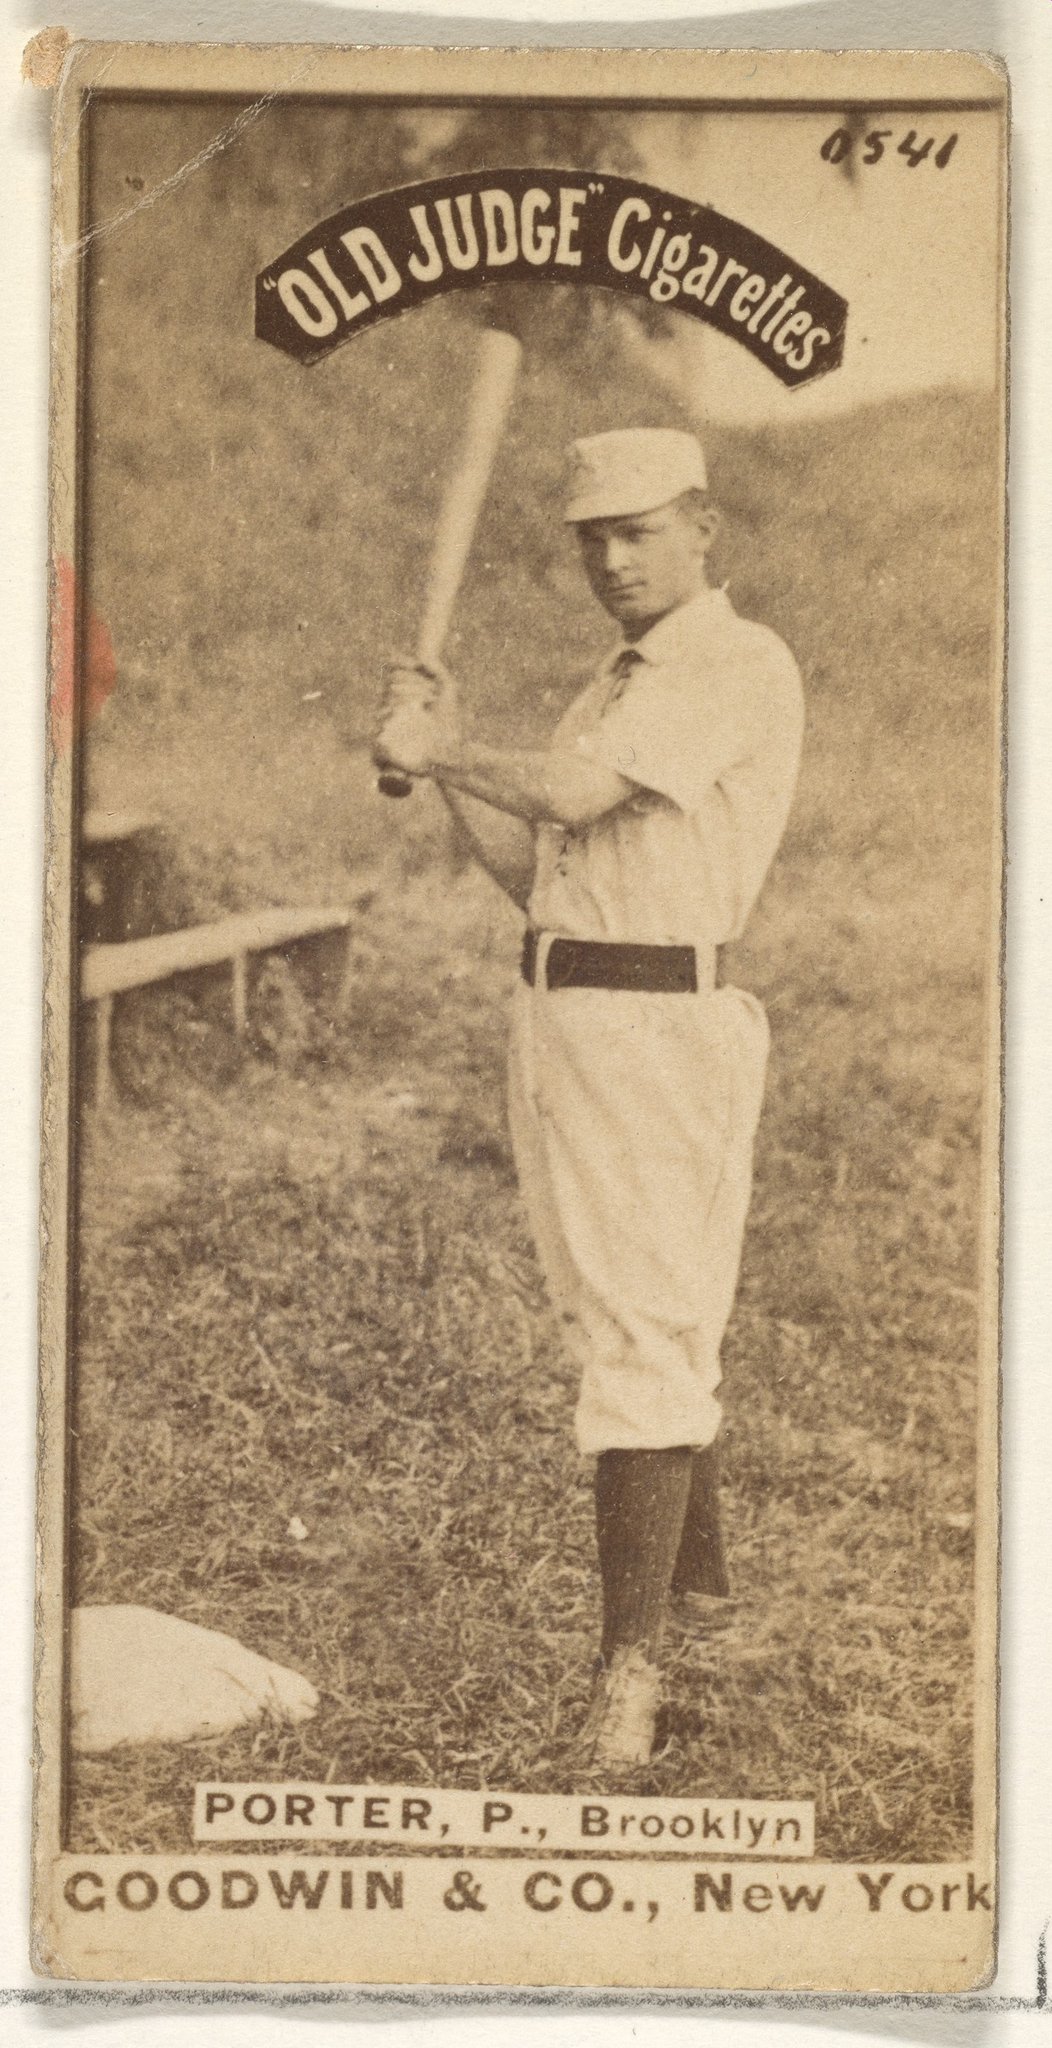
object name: baseball card, photograph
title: Porter, Pitcher, Brooklyn, from the Old Judge series (N172) for Old Judge Cigarettes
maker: goodwin & company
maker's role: publisher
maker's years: 1850-1950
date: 1887-1890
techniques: albumen silver print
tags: men,portraits,baseball,athletes